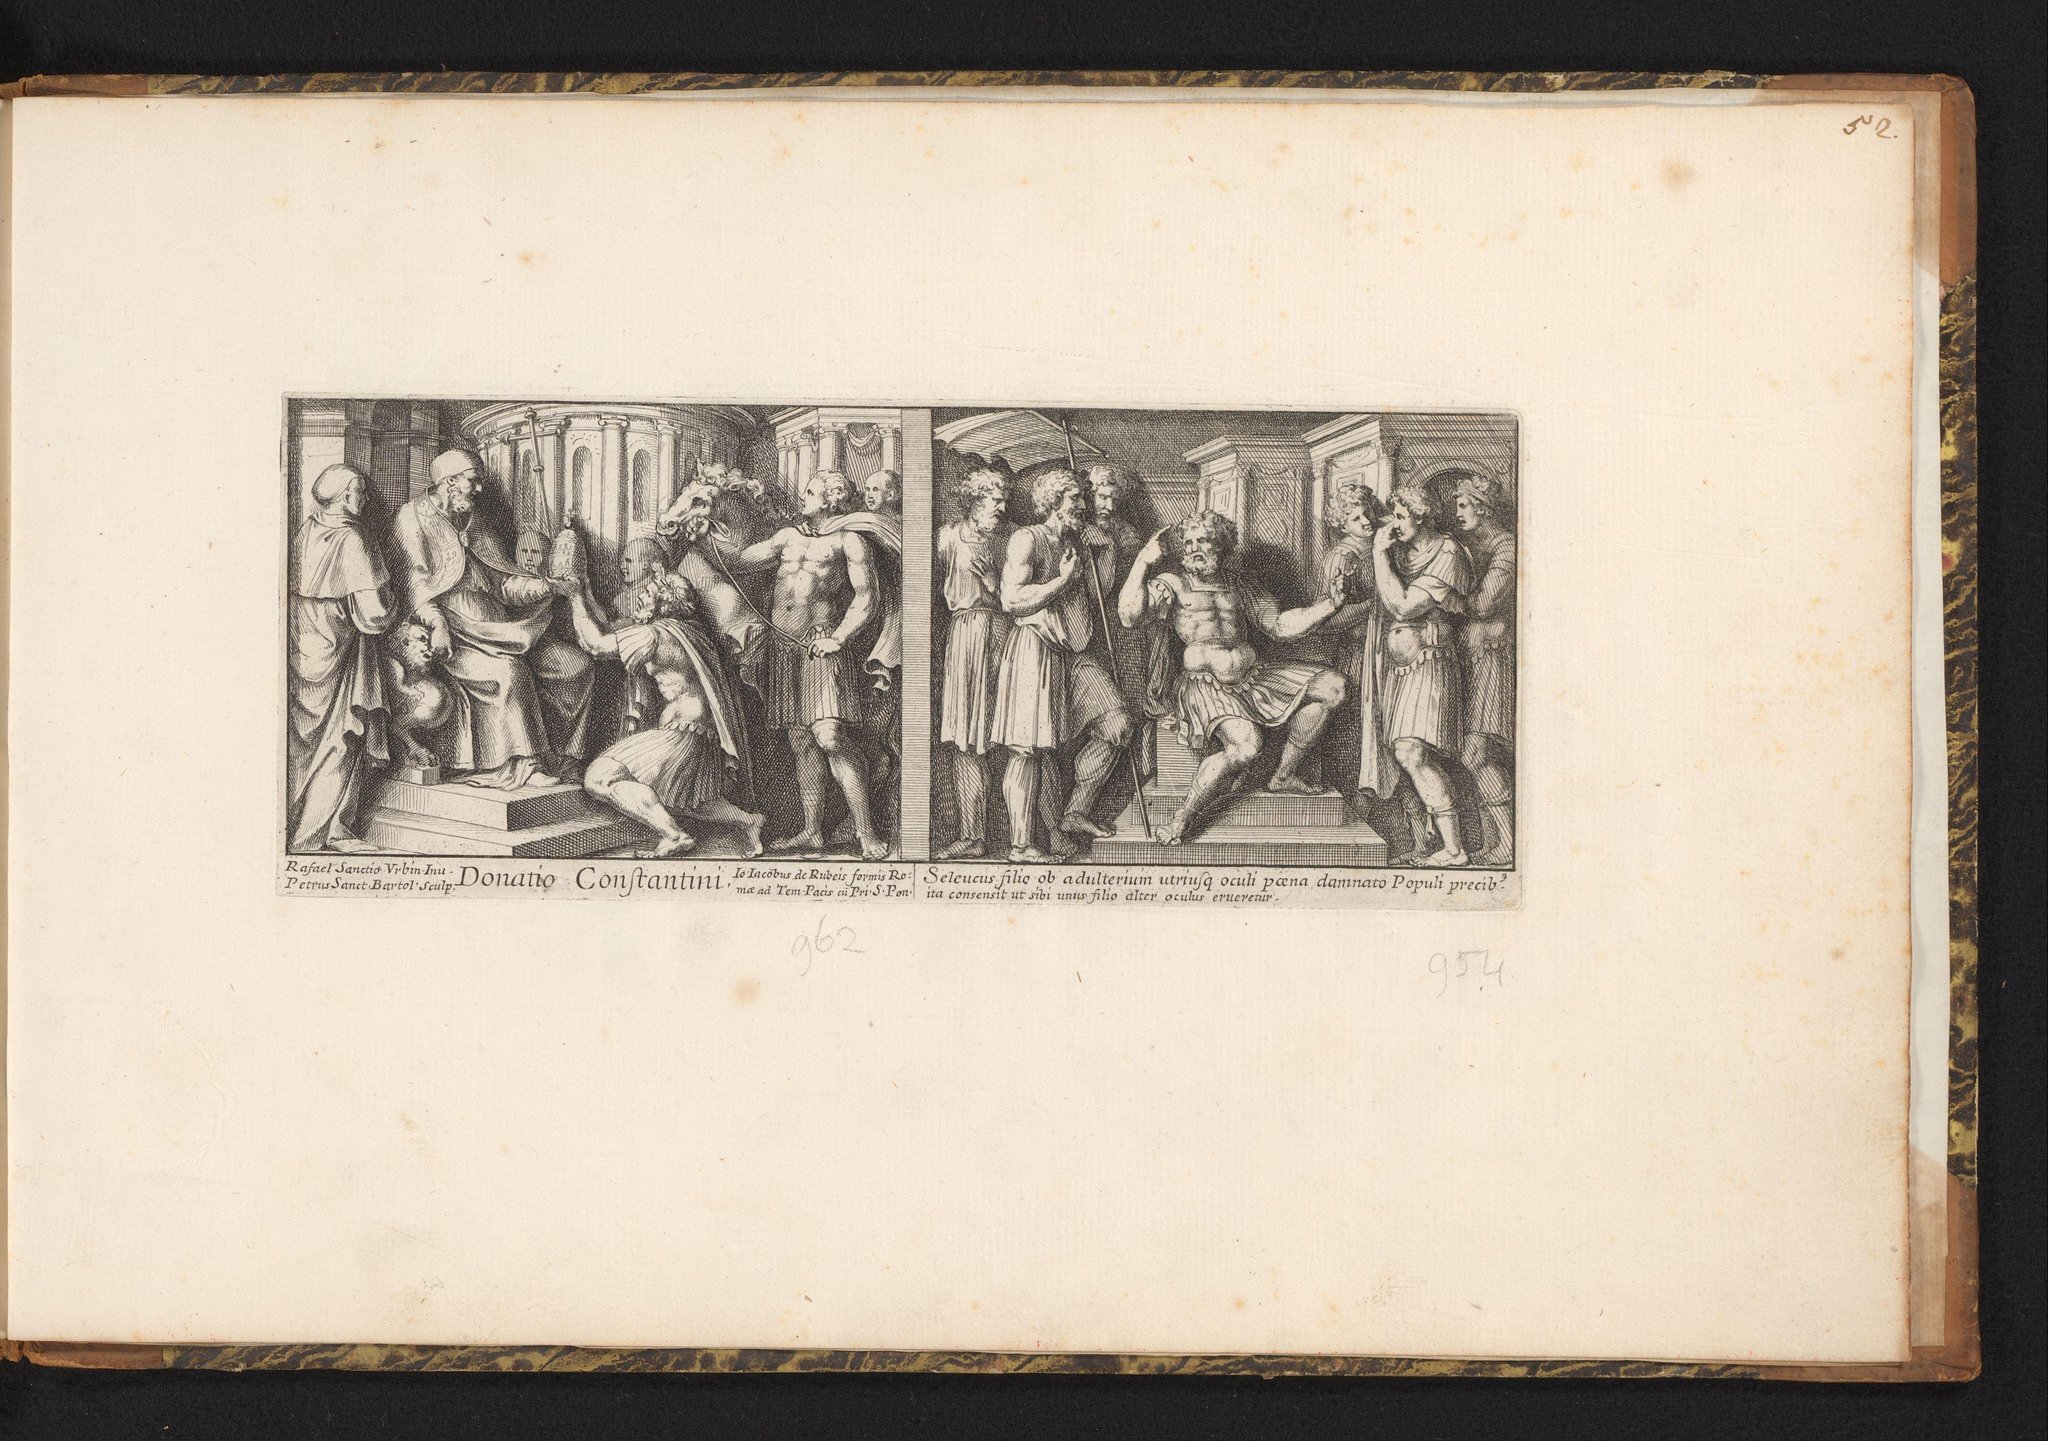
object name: album leaf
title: Keizer Constantijn overhandigt Rome aan paus Silvester I en het Seleucidische oordeel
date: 1645-1700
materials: paper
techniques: engraving, etching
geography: vatican city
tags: throne, ruler, sovereign, pope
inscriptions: number: ‘52’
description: Prent uit een reeks van 14 prenten (+ titelprent) naar schilderingen door Rafaël in de Stanze di Raffaello in het Apostolisch Paleis in het Vaticaan en naar ontwerpen voor wandtapijten voor de Sixtijnse Kapel door Rafaël. Linker voorstelling naar een schildering door Rafaël in de Stanza di Eliodoro. Rechter voorstelling naar een schildering door Rafaël in de Stanza della Segnatura.